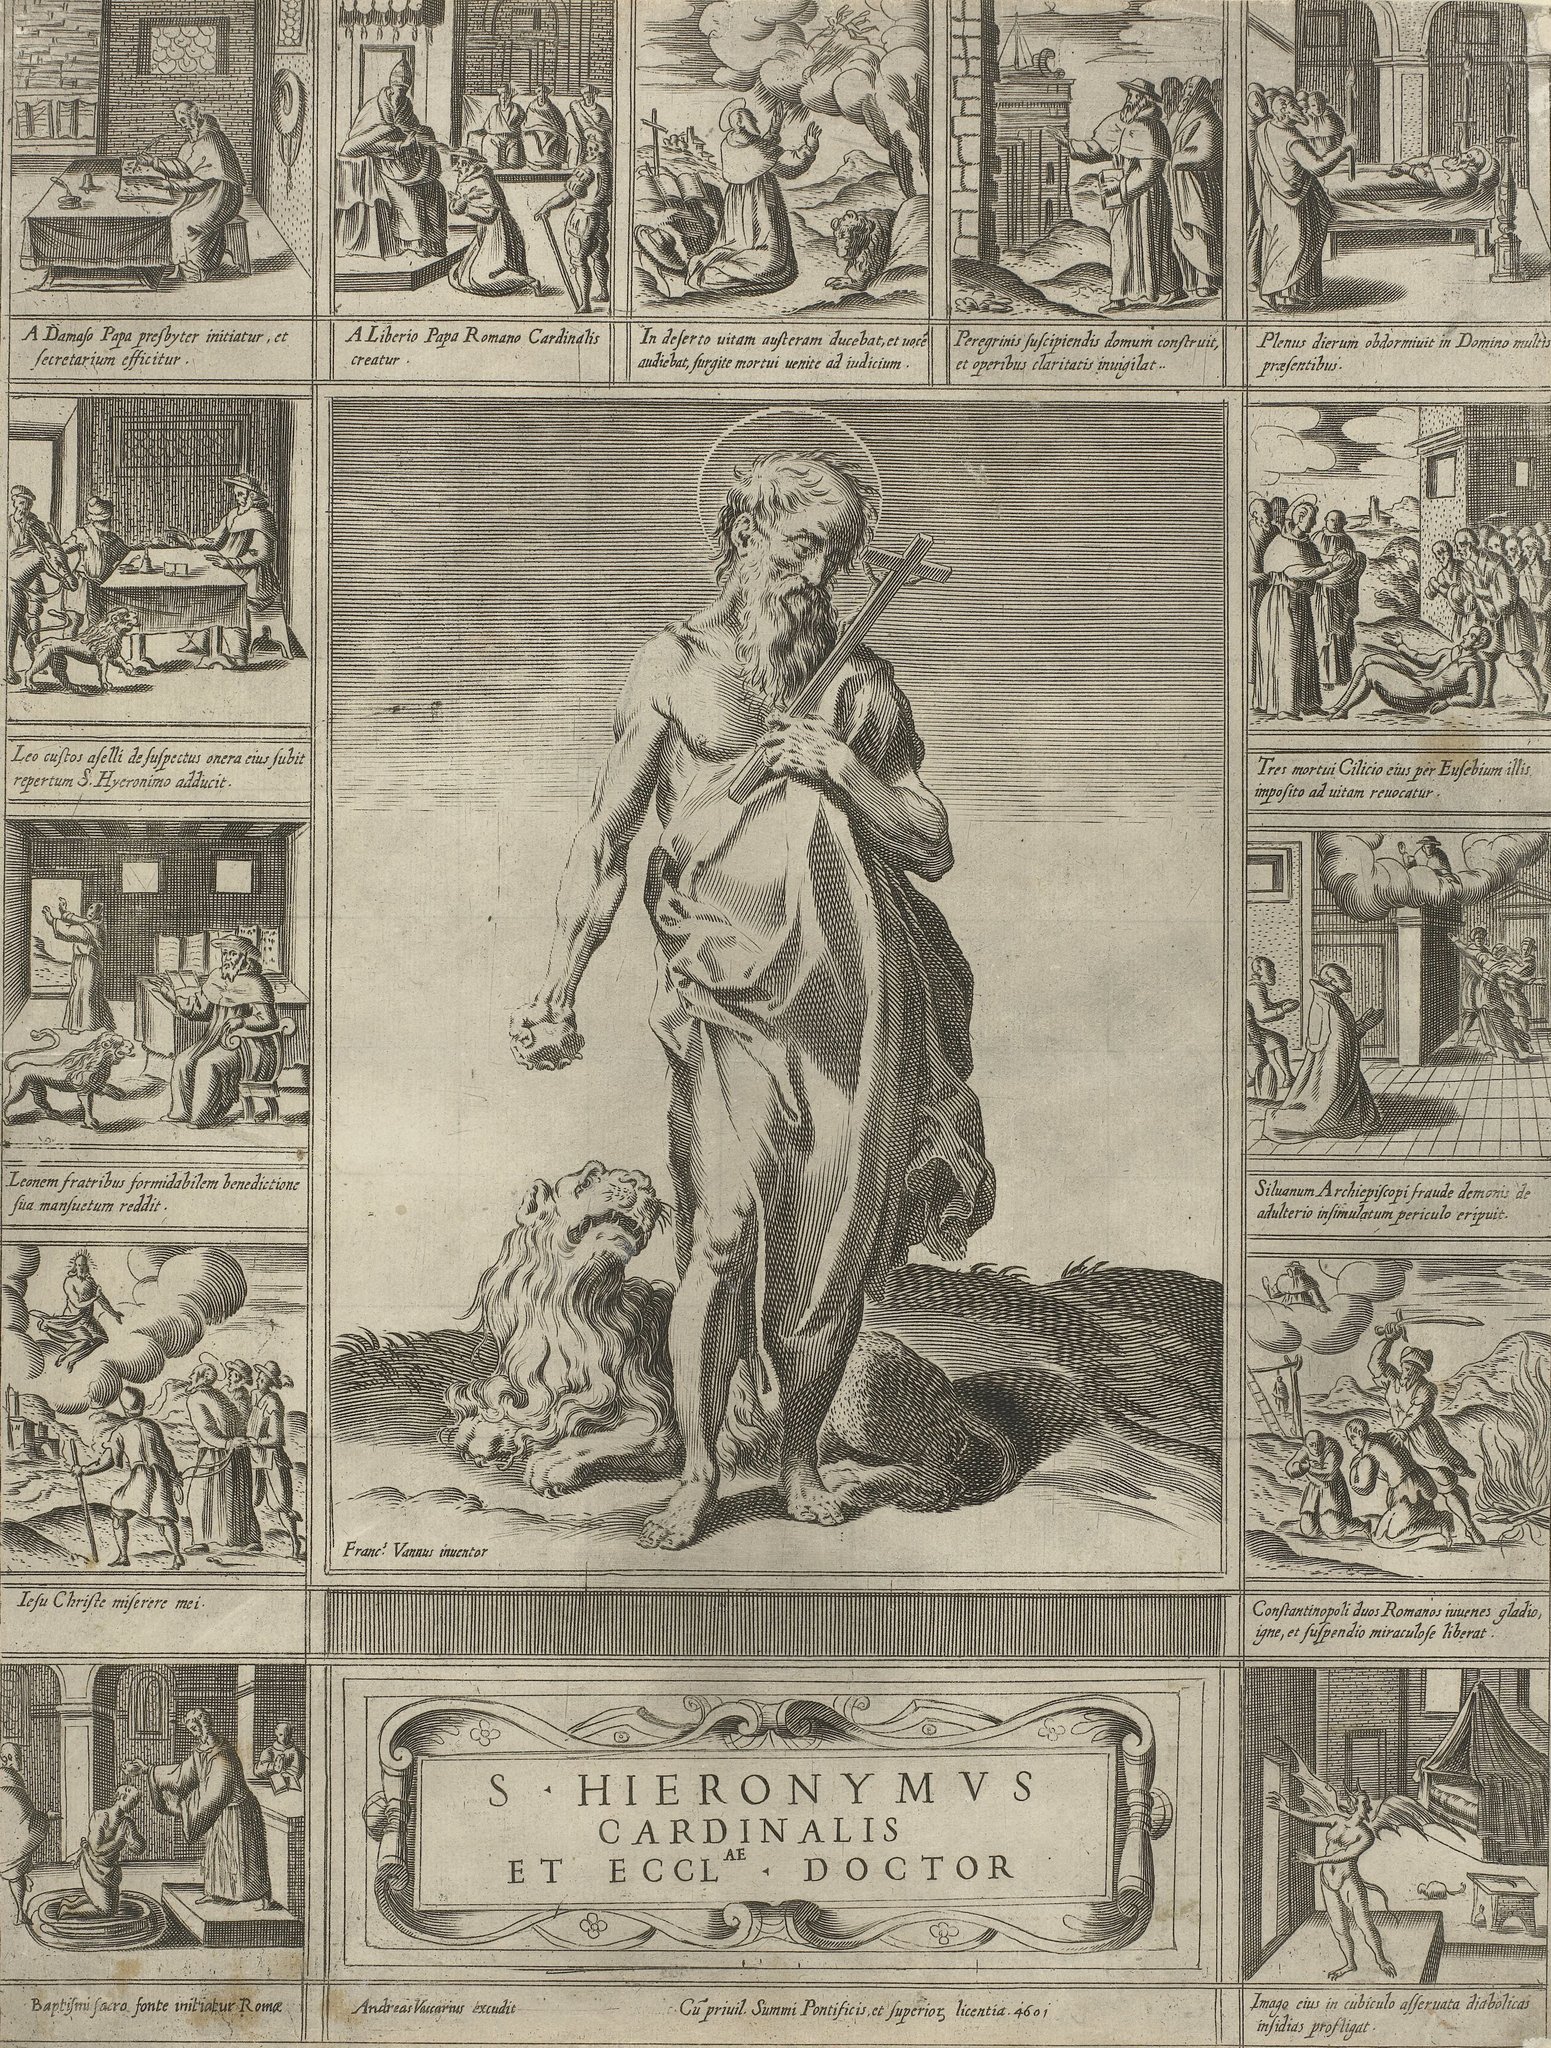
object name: print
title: Leven van de heilige Hieronymus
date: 1604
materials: paper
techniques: engraving, etching, intaglio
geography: italy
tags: miraculous activities and events ~ st. jerome - stigmatization of male saint, st. jerome as penitent in his study, the monk and hermit jerome (hieronymus); possible attributes: book, cardinal's hat, crucifix, hour-glass, lion, skull, stone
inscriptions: collector's mark: Lugt 240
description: Deze prent maakt deel uit van een door Andrea Vaccari uitgegeven serie, bestaande uit ten minste tien prenten met voorstellingen van heiligen, omringd door kleinere voorstellingen met scènes uit het leven van desbetreffende heilige.